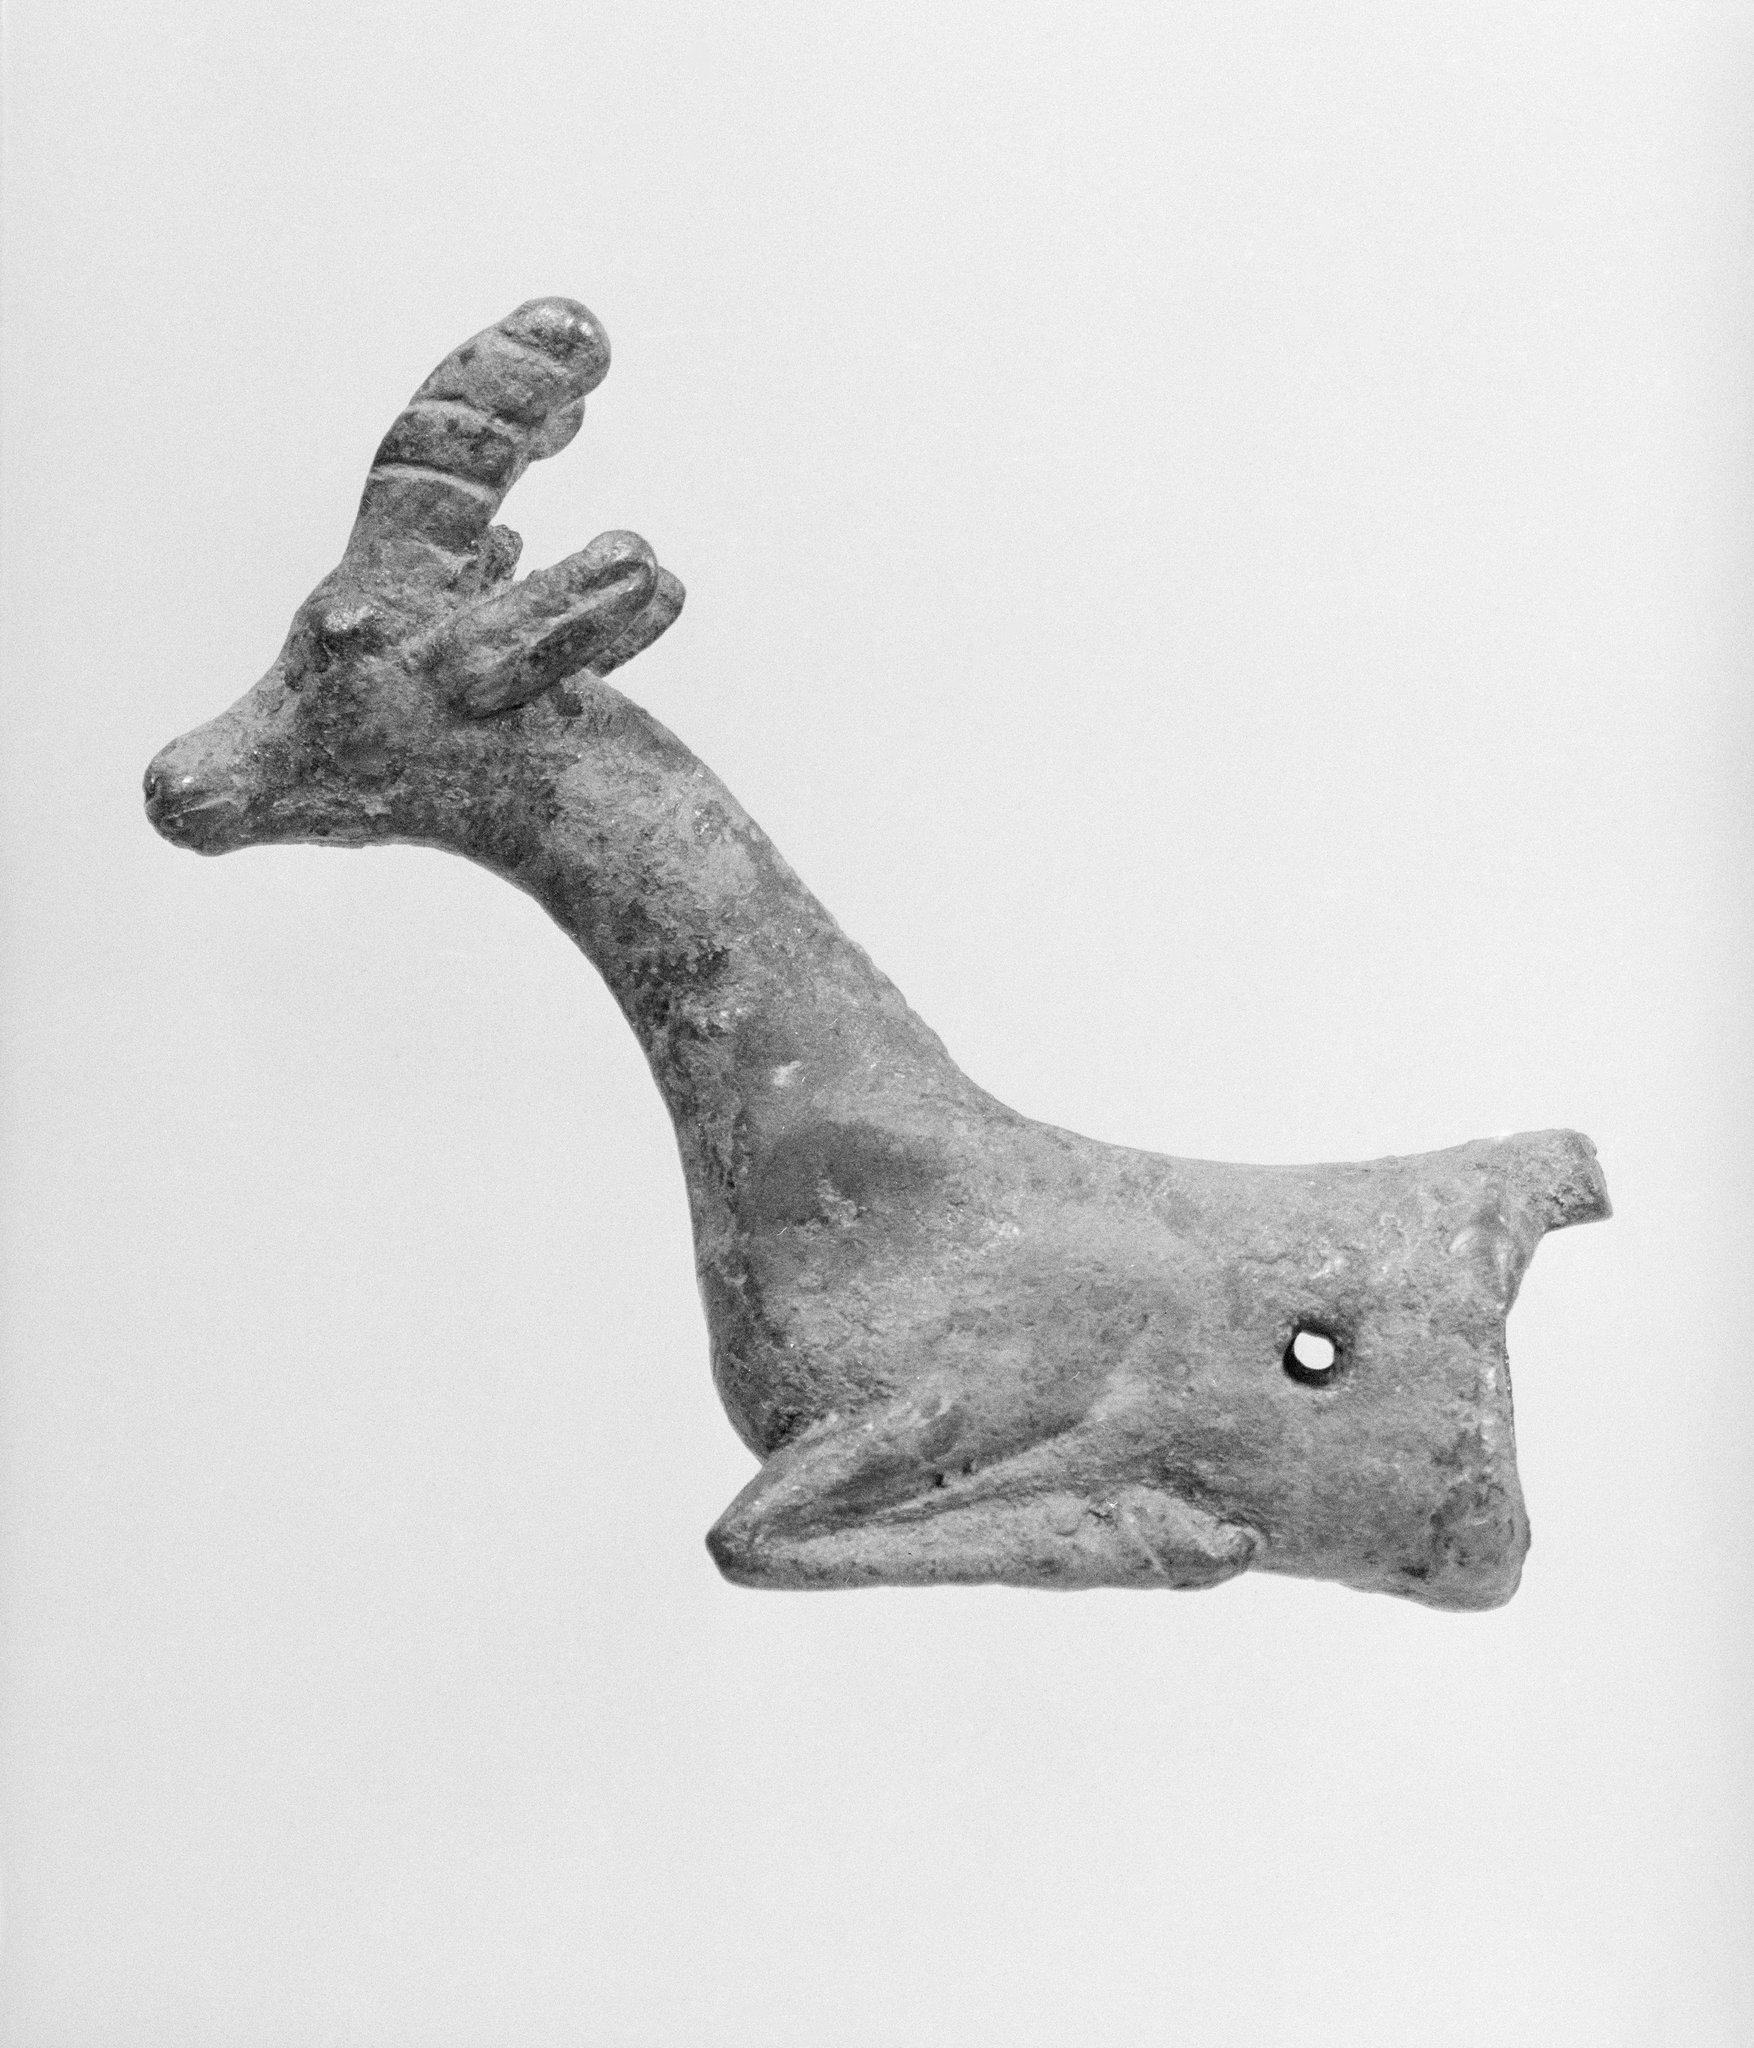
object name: whetstone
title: Whetstone handle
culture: iranian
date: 1000-668 BCE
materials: bronze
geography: iran, probably from luristan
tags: animals